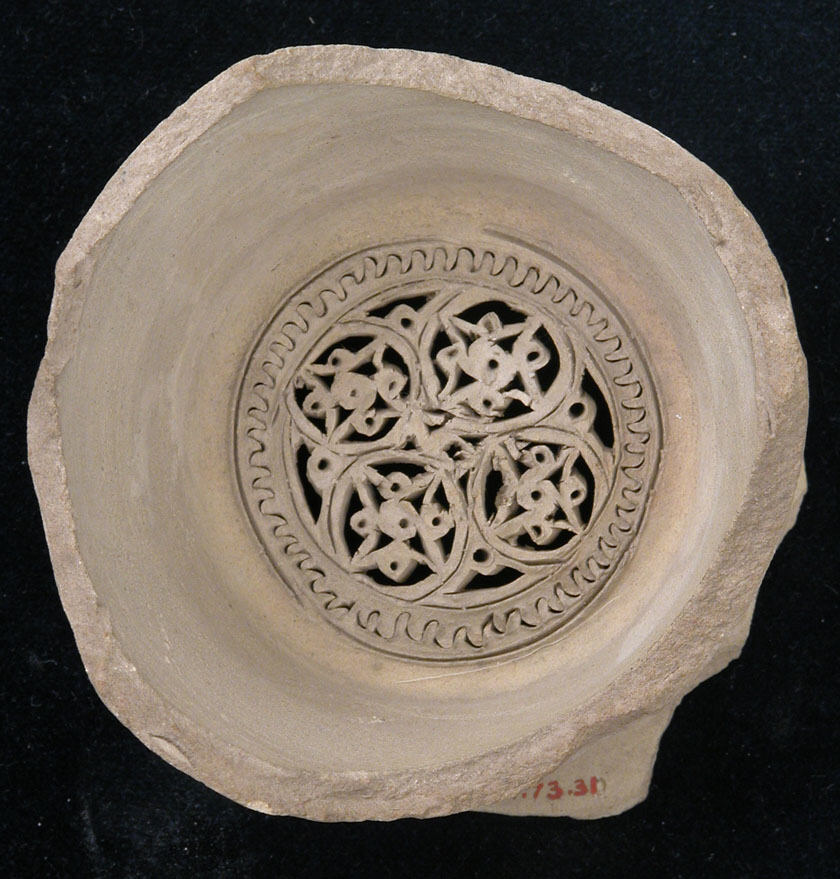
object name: water filter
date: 901-1200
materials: earthenware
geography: egypt